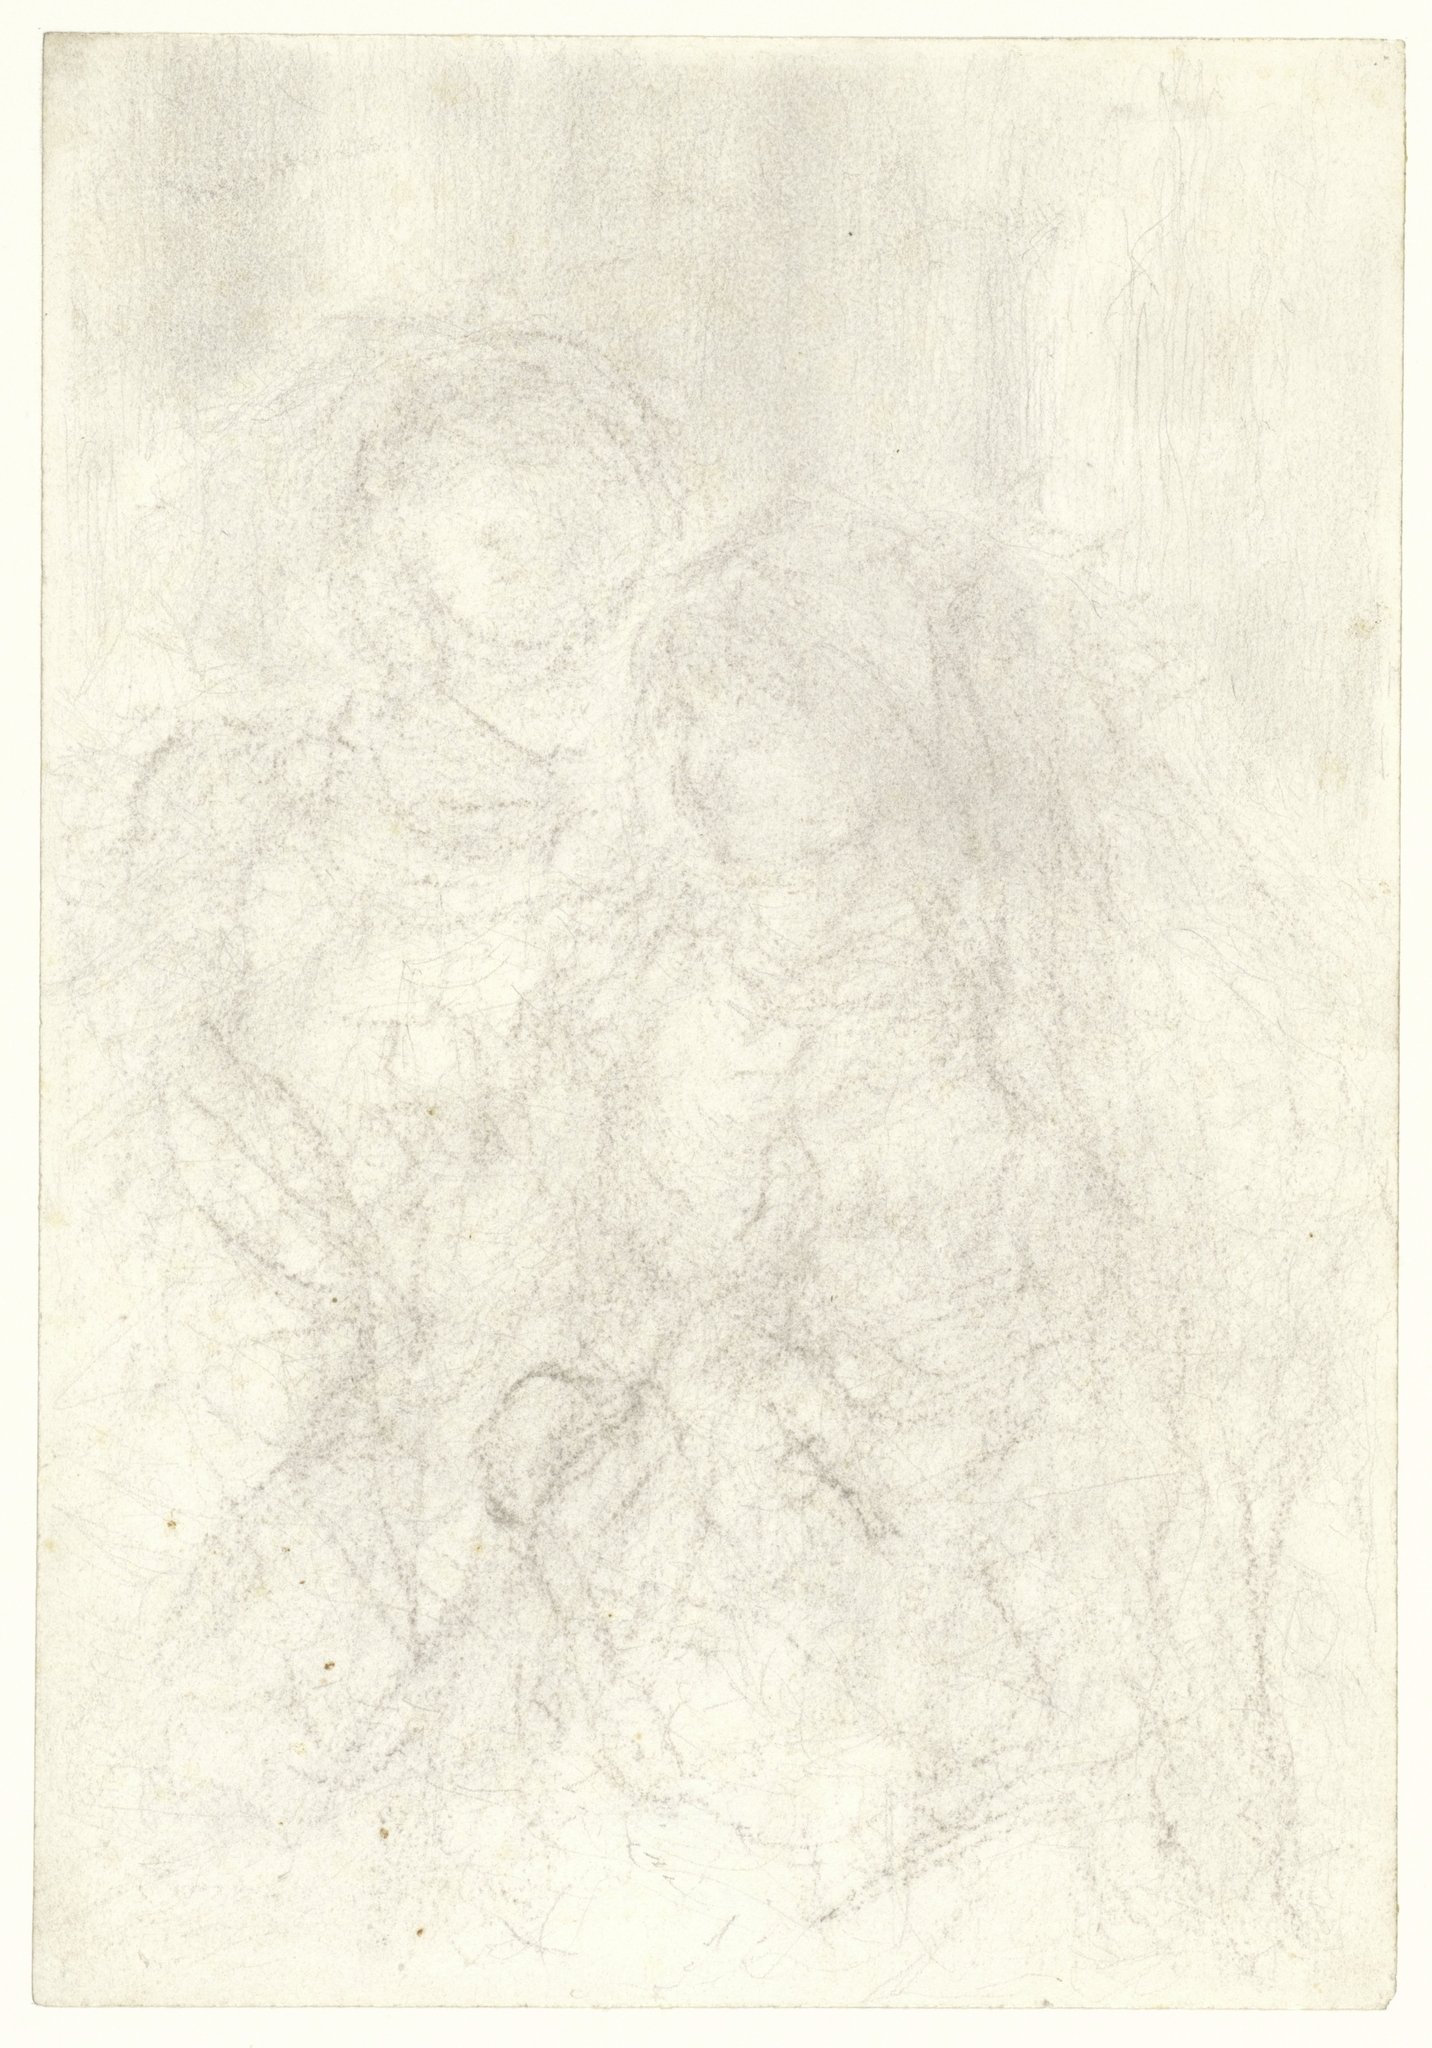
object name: drawing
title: Twee figuren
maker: matthijs maris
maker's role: draughtsman, painter, print maker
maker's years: 1839-1917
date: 1849-1917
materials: chalk, paper